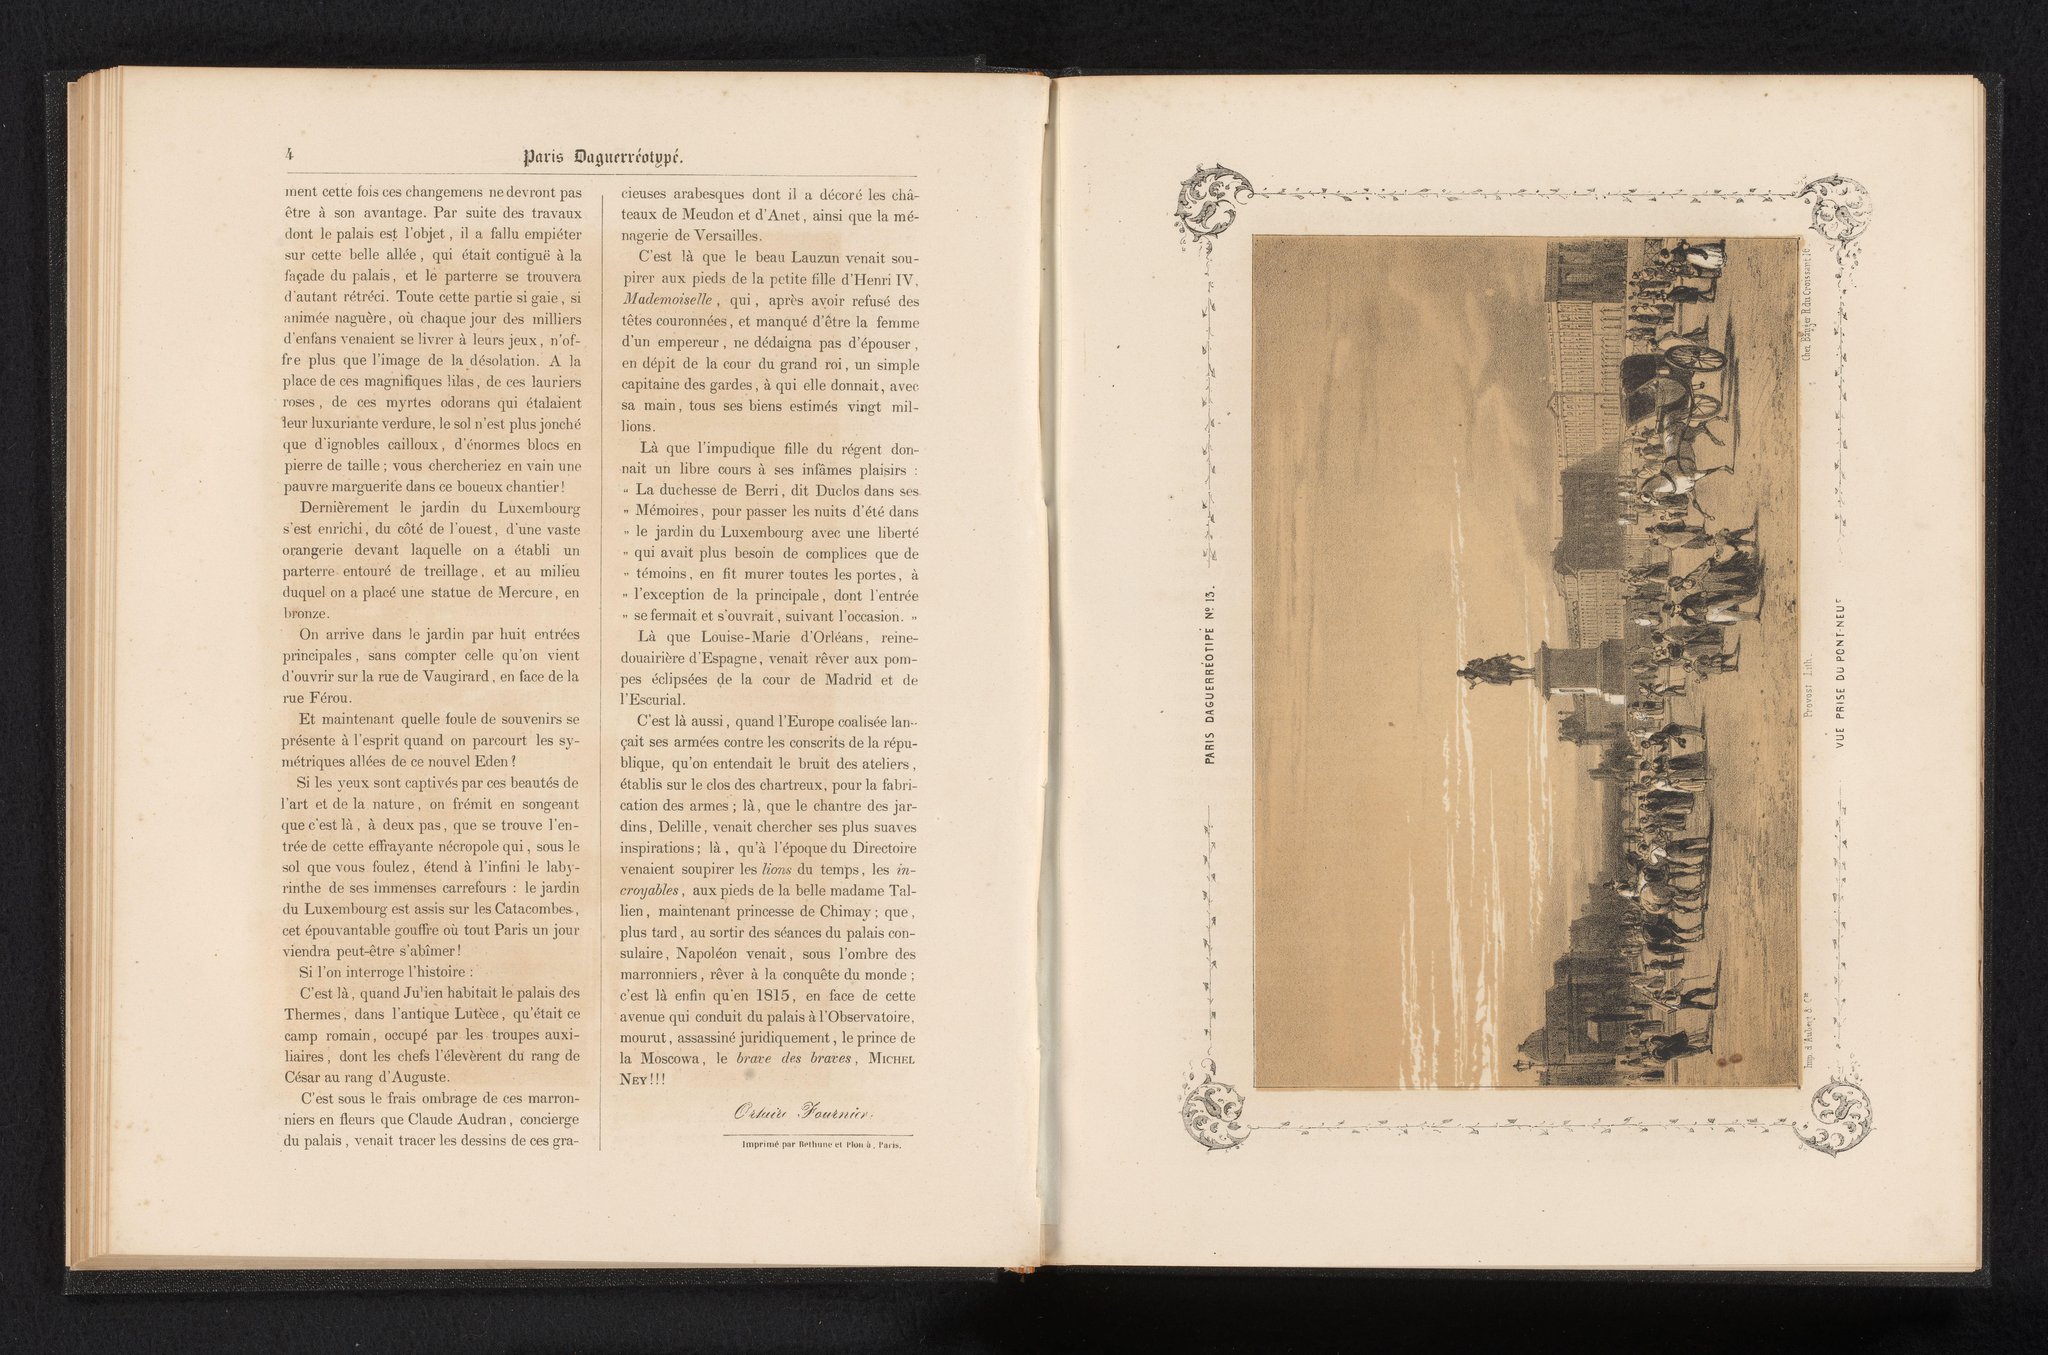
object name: page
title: Vue pris du Pont Neuf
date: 1839-1840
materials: paper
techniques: tone lithography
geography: paris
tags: city-view in general; 'veduta'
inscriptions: inscription: ‘PARIS DAGUERRÉOTYPÉ No. 13.’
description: Prent op negenenveertigste ongenummerde pagina.